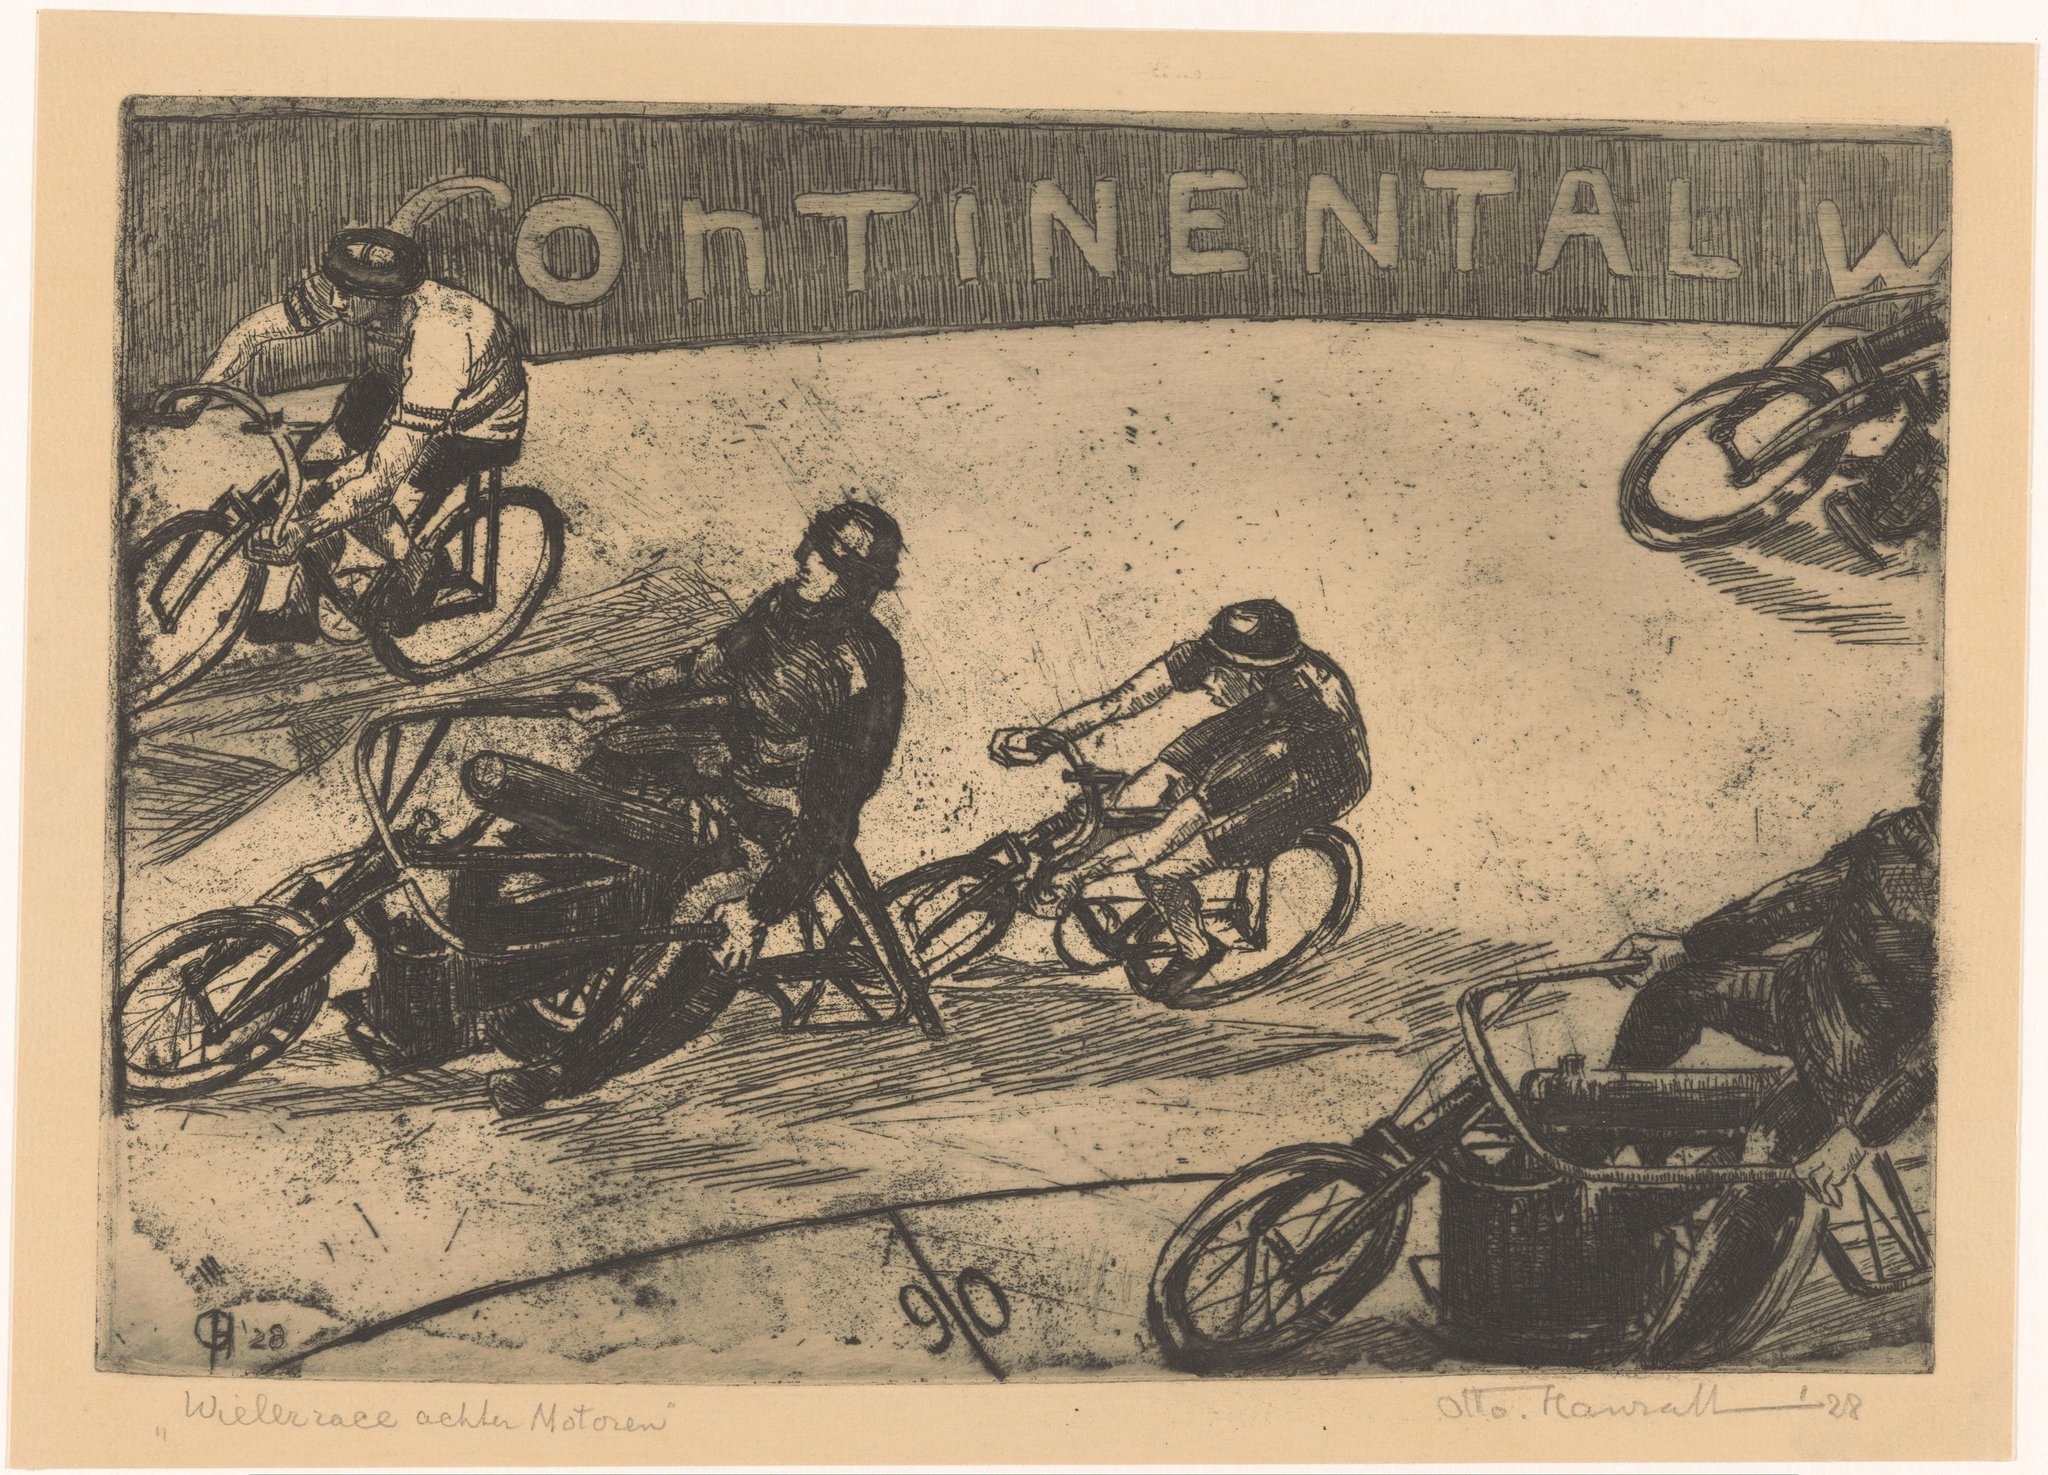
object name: print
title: Wielerrace achter motoren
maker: otto hanrath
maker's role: print maker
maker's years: 1882-1944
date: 1928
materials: paper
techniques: etching, intaglio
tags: bicycle racing, motor-cycles and other two-wheeled motor-vehicles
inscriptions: collector's mark: Lugt 2228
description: Motorrijders en wielrenners op een wielrenbaan. Op de achtergrond een reclamebord met de tekst 'Continental' langs de baan.